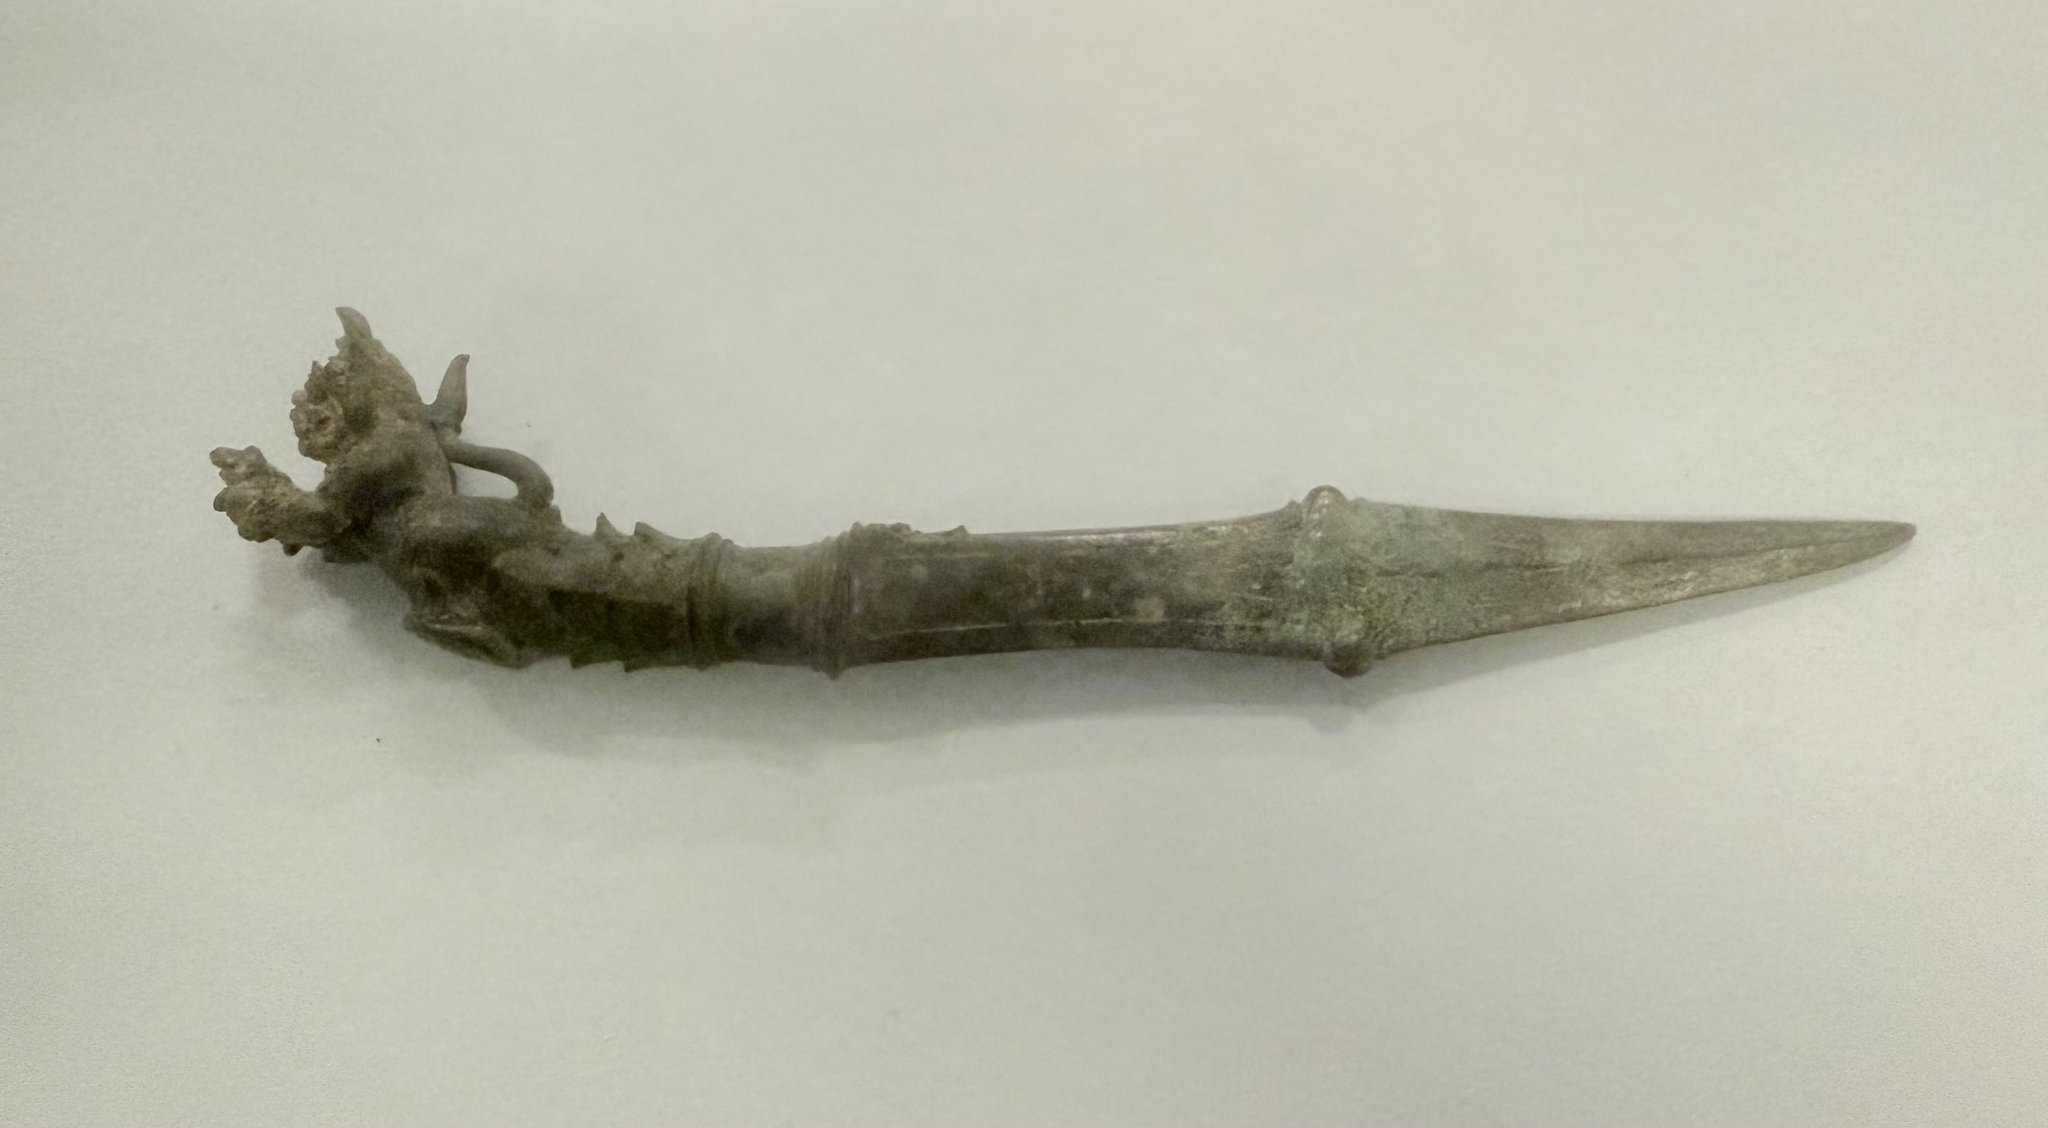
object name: knife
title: Knife with Handle in the form of a Lion Clutching Elephants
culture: cambodian or thai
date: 1134-1166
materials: bronze, gilt